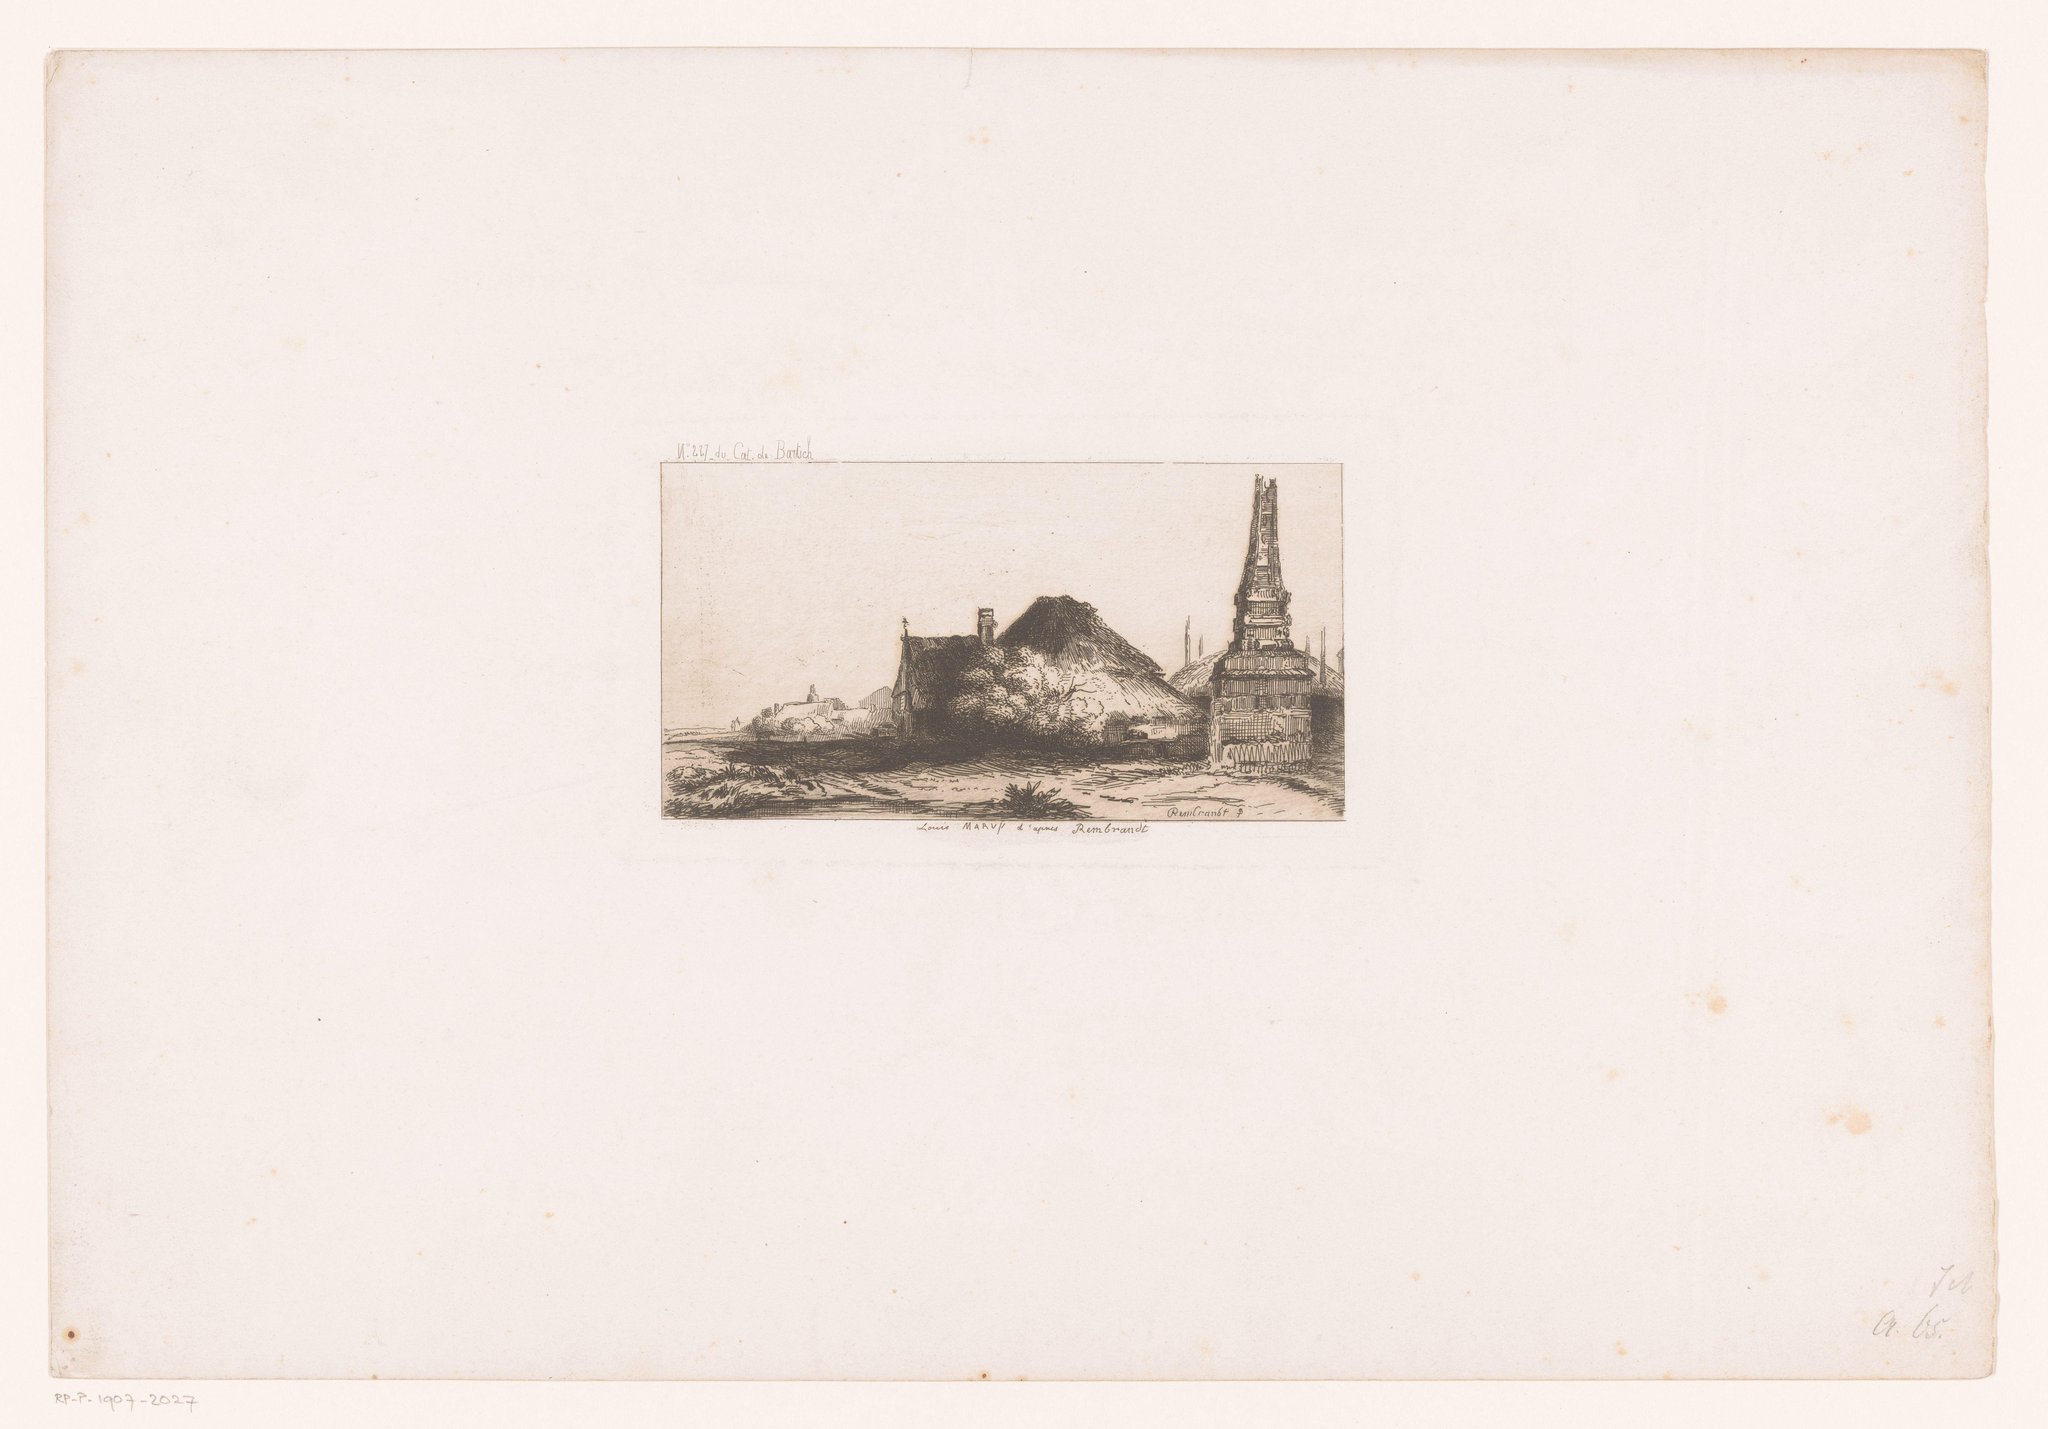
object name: print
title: De obelisk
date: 1825-1850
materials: paper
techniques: etching, intaglio, roulette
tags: city-view, and landscape with man-made constructions, hut, cabin, lodge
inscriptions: check stamp, collector's mark: Lugt 2228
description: Genummerd linksboven: No 227 du Cat. de Bartsch.